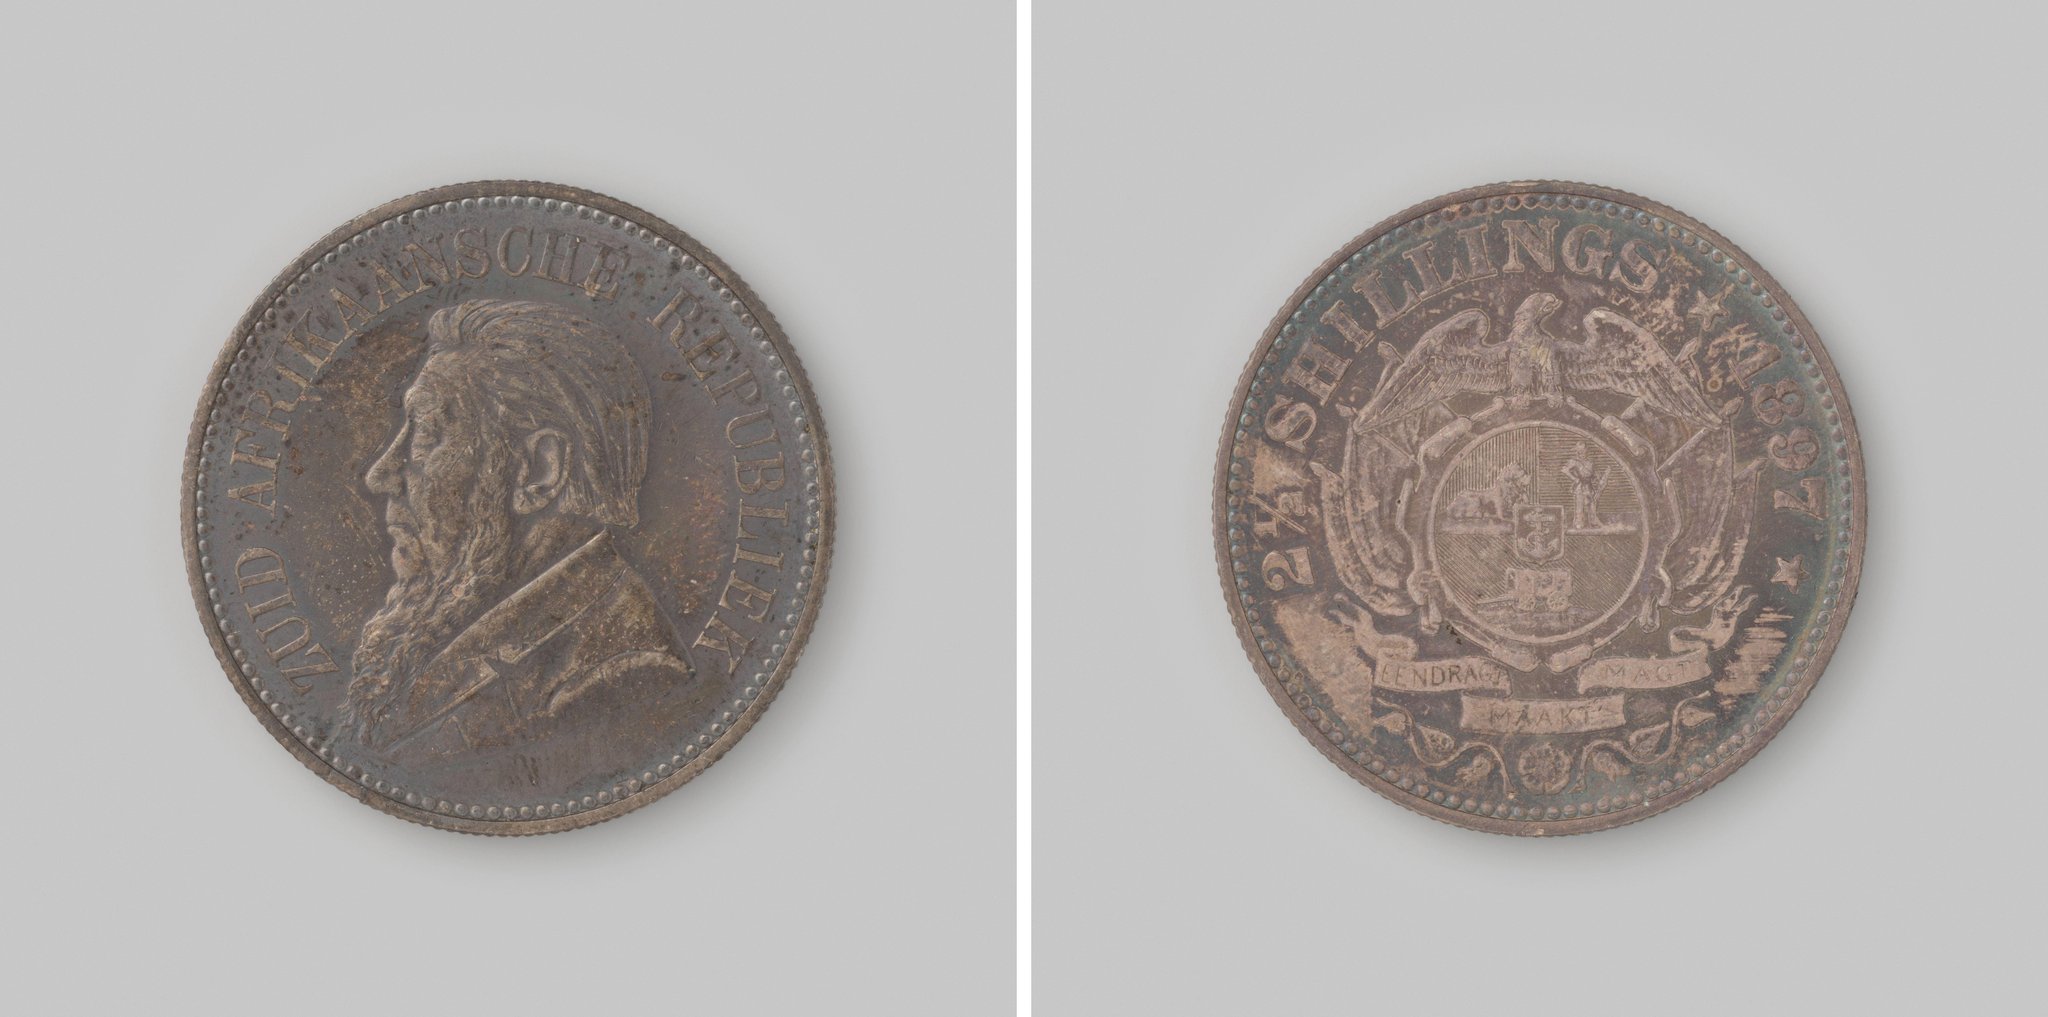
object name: coin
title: Zuid-Afrika, Zuidafrikaansche Republiek (Z.A.R.), 2½ shillings, 1897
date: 1897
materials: silver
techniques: striking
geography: pretoria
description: Zilveren munt. Voorzijde: borstbeeld van president Krüger naar links. Omschrift: Zuid Afrikaansche Republiek. Keerzijde: binnen een stel vlaggen, waarboven adelaar en waaronder banderol met wapenspreuk rond wapenschild van de Z.A.R. Bovenaan waarde-aanduiding met rechts jaartal.